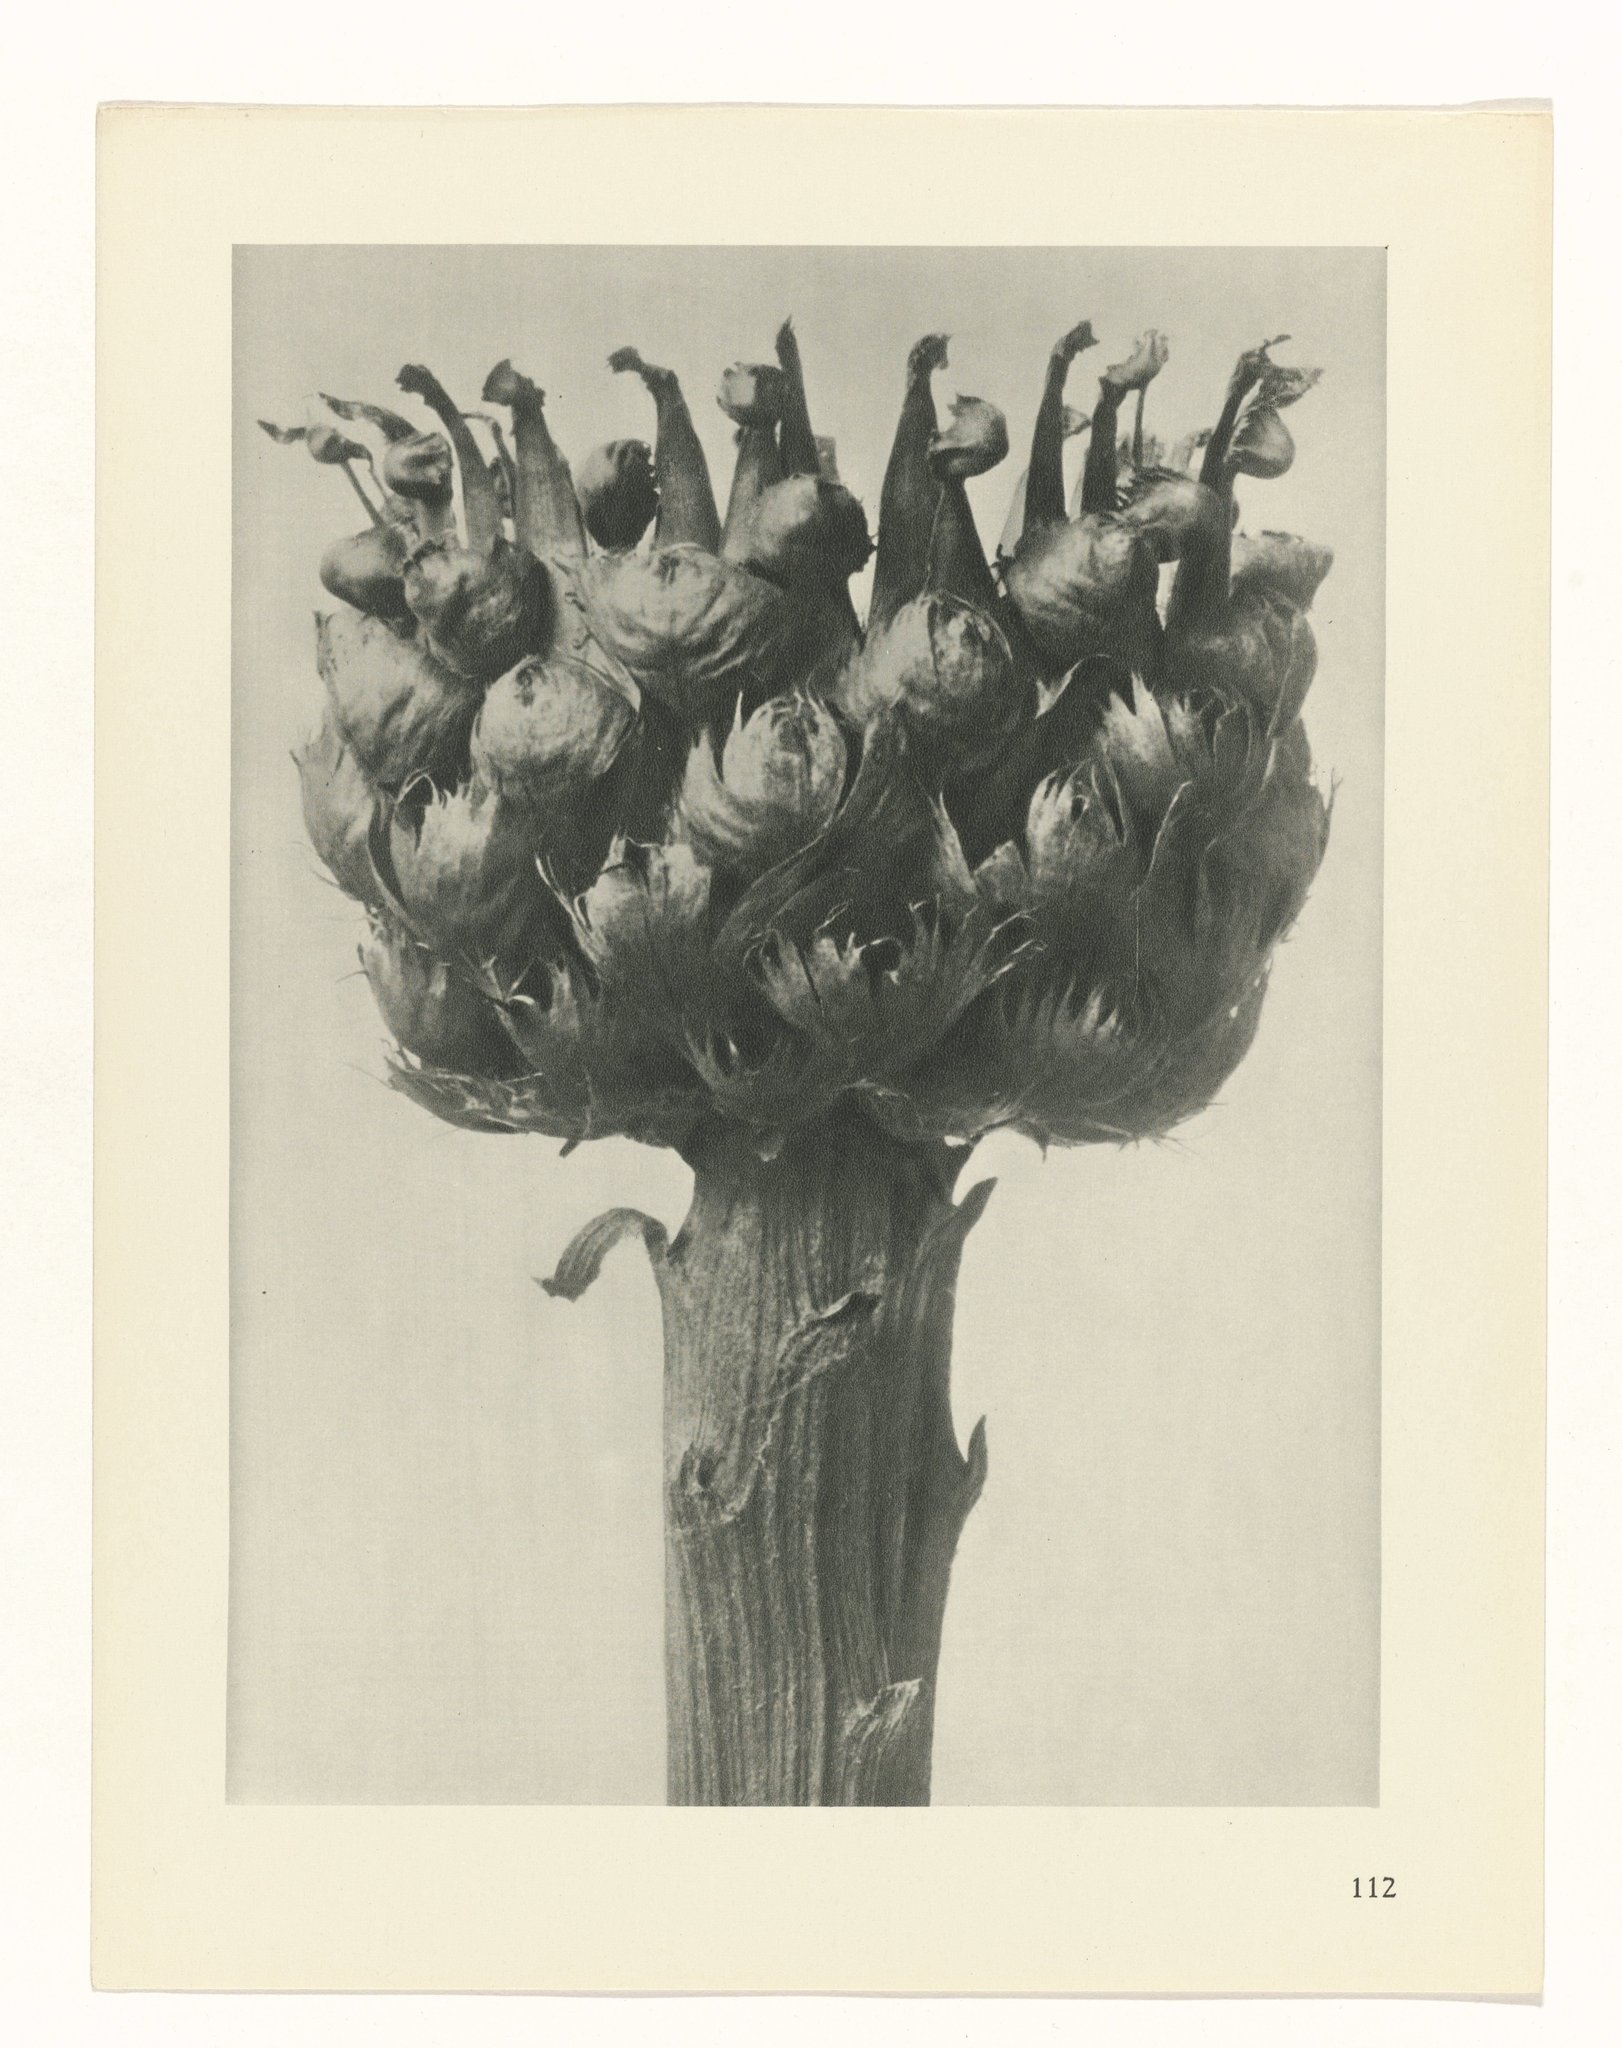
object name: photograph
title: Plantstudie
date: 1928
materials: ink, paper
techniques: rotogravure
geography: berlin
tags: plants (in general)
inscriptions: number: ‘112’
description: facher Vergrößerung. Afkomstig uit losbladige uitgave.